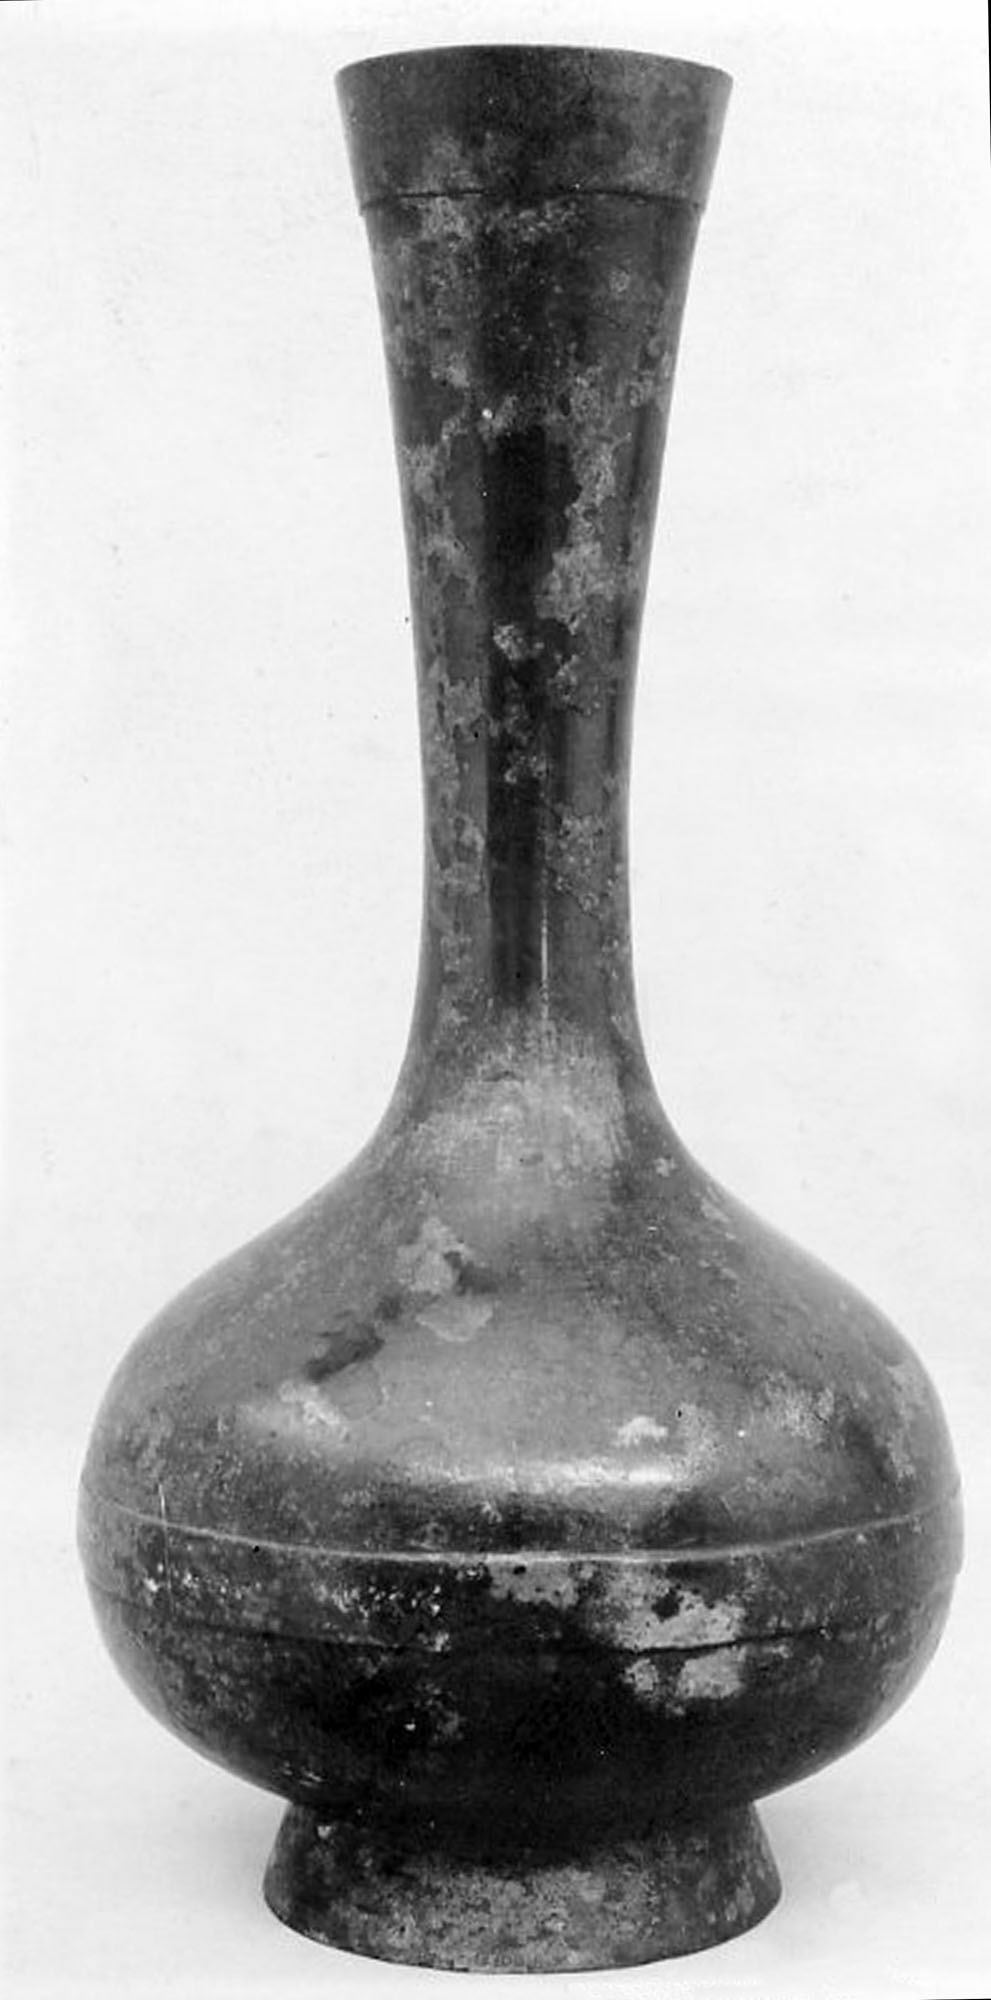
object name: wine container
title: Wine container (Hu)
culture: chinese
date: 206 BCE-220 CE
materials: bronze